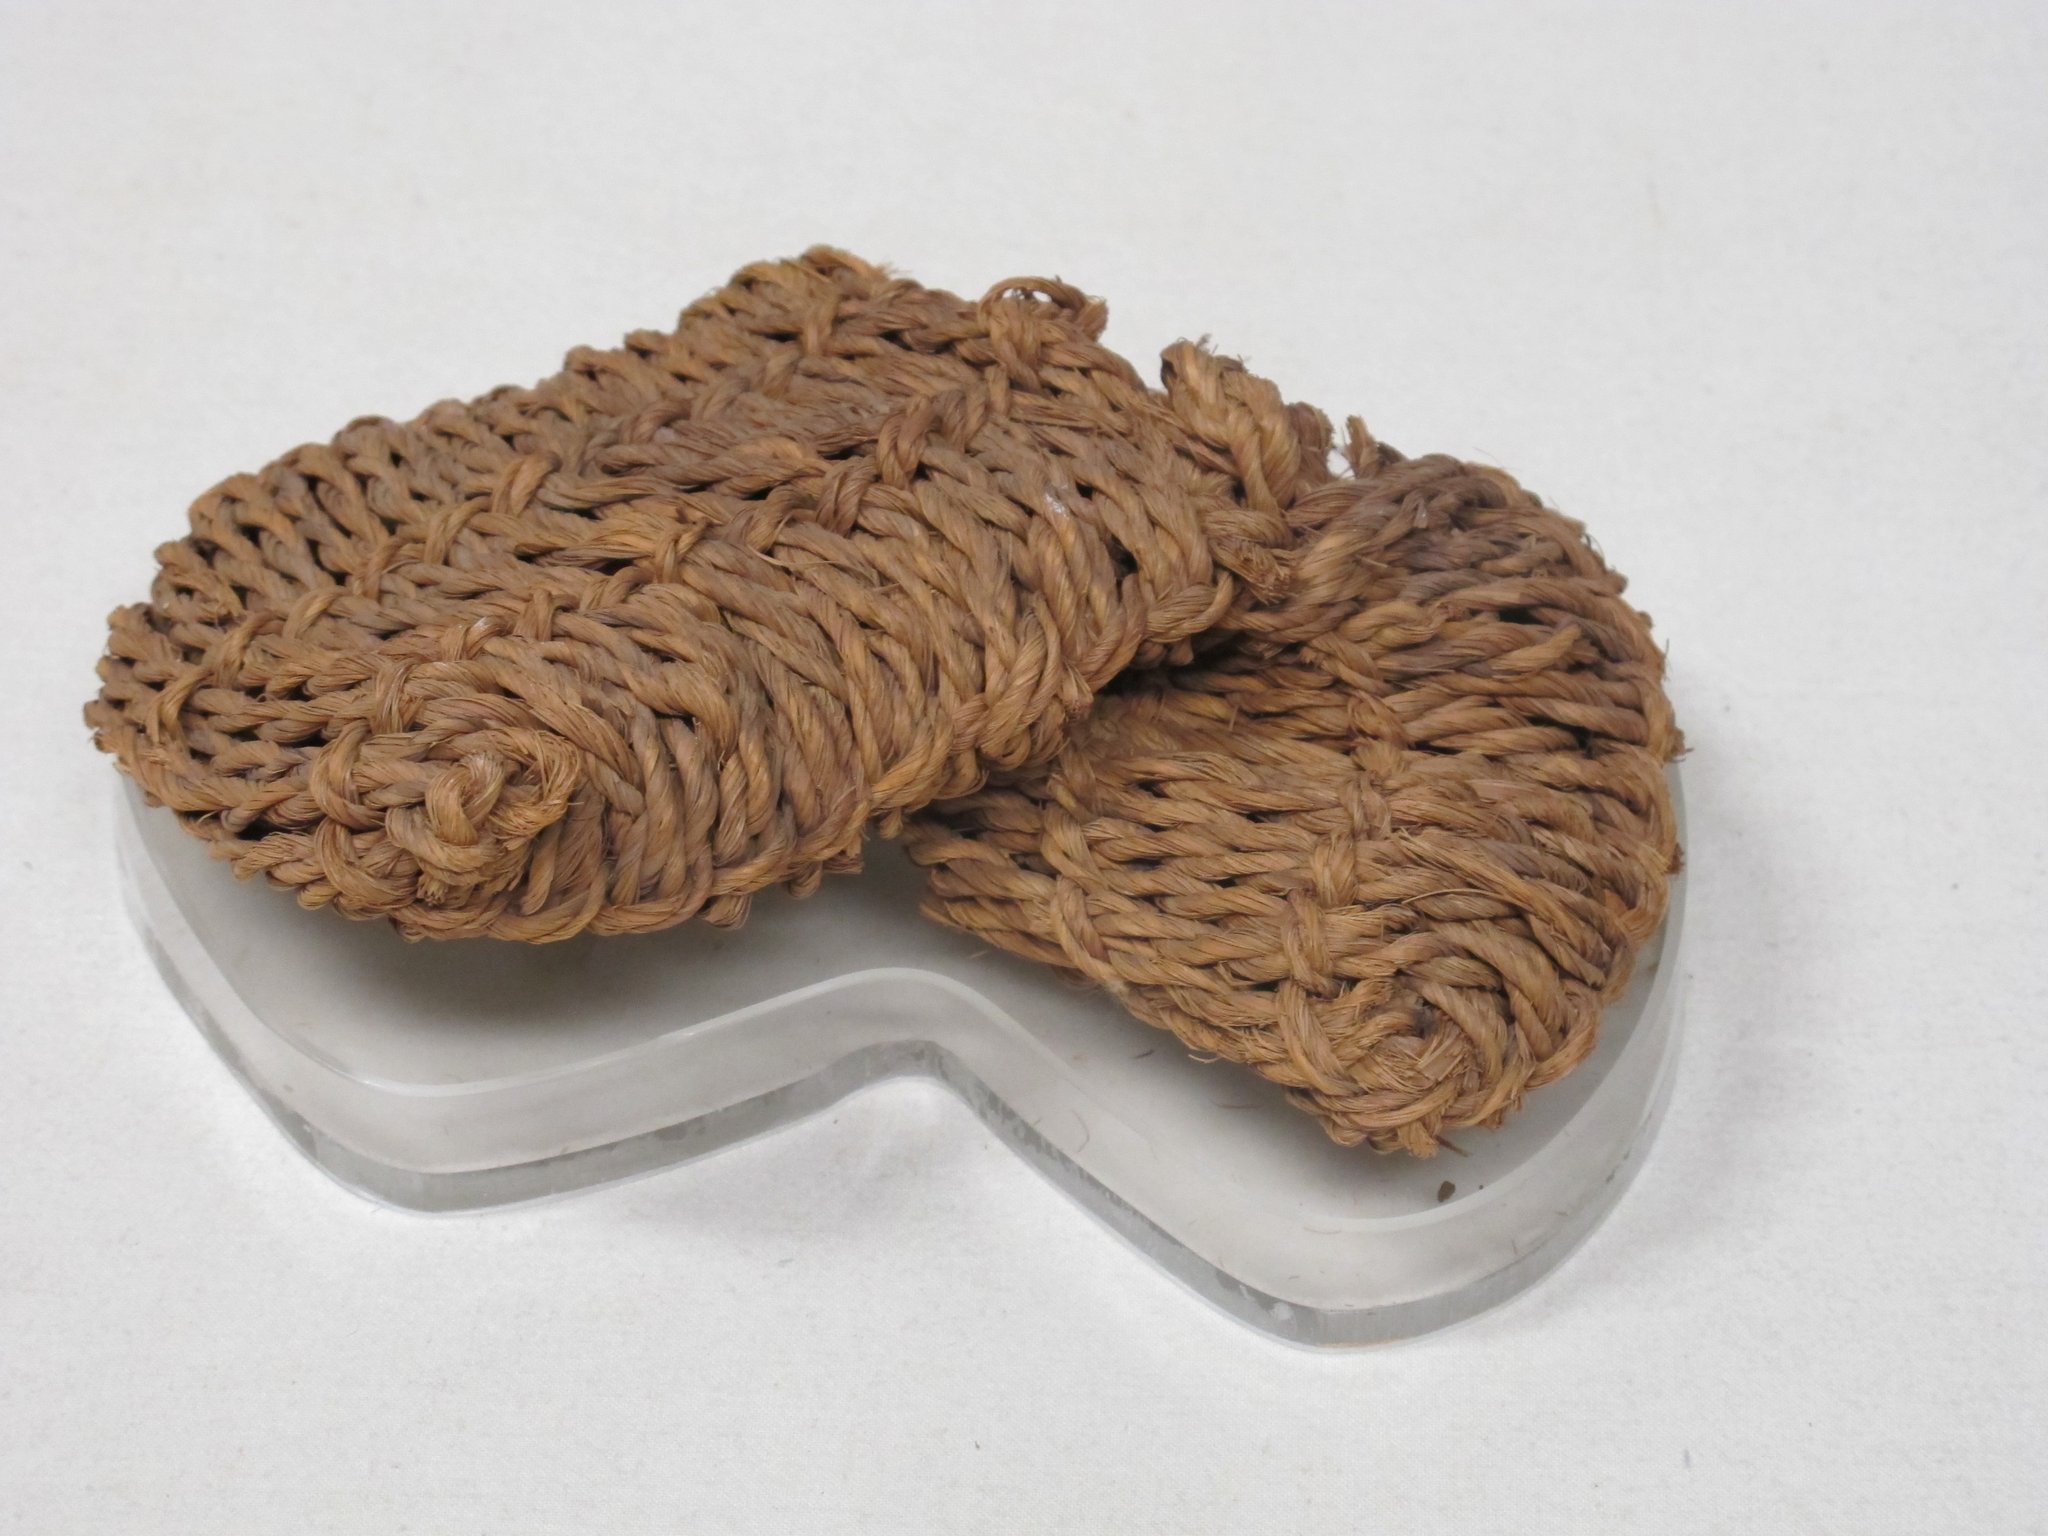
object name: model donkey bag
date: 2030-1640 BCE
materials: fiber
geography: egypt